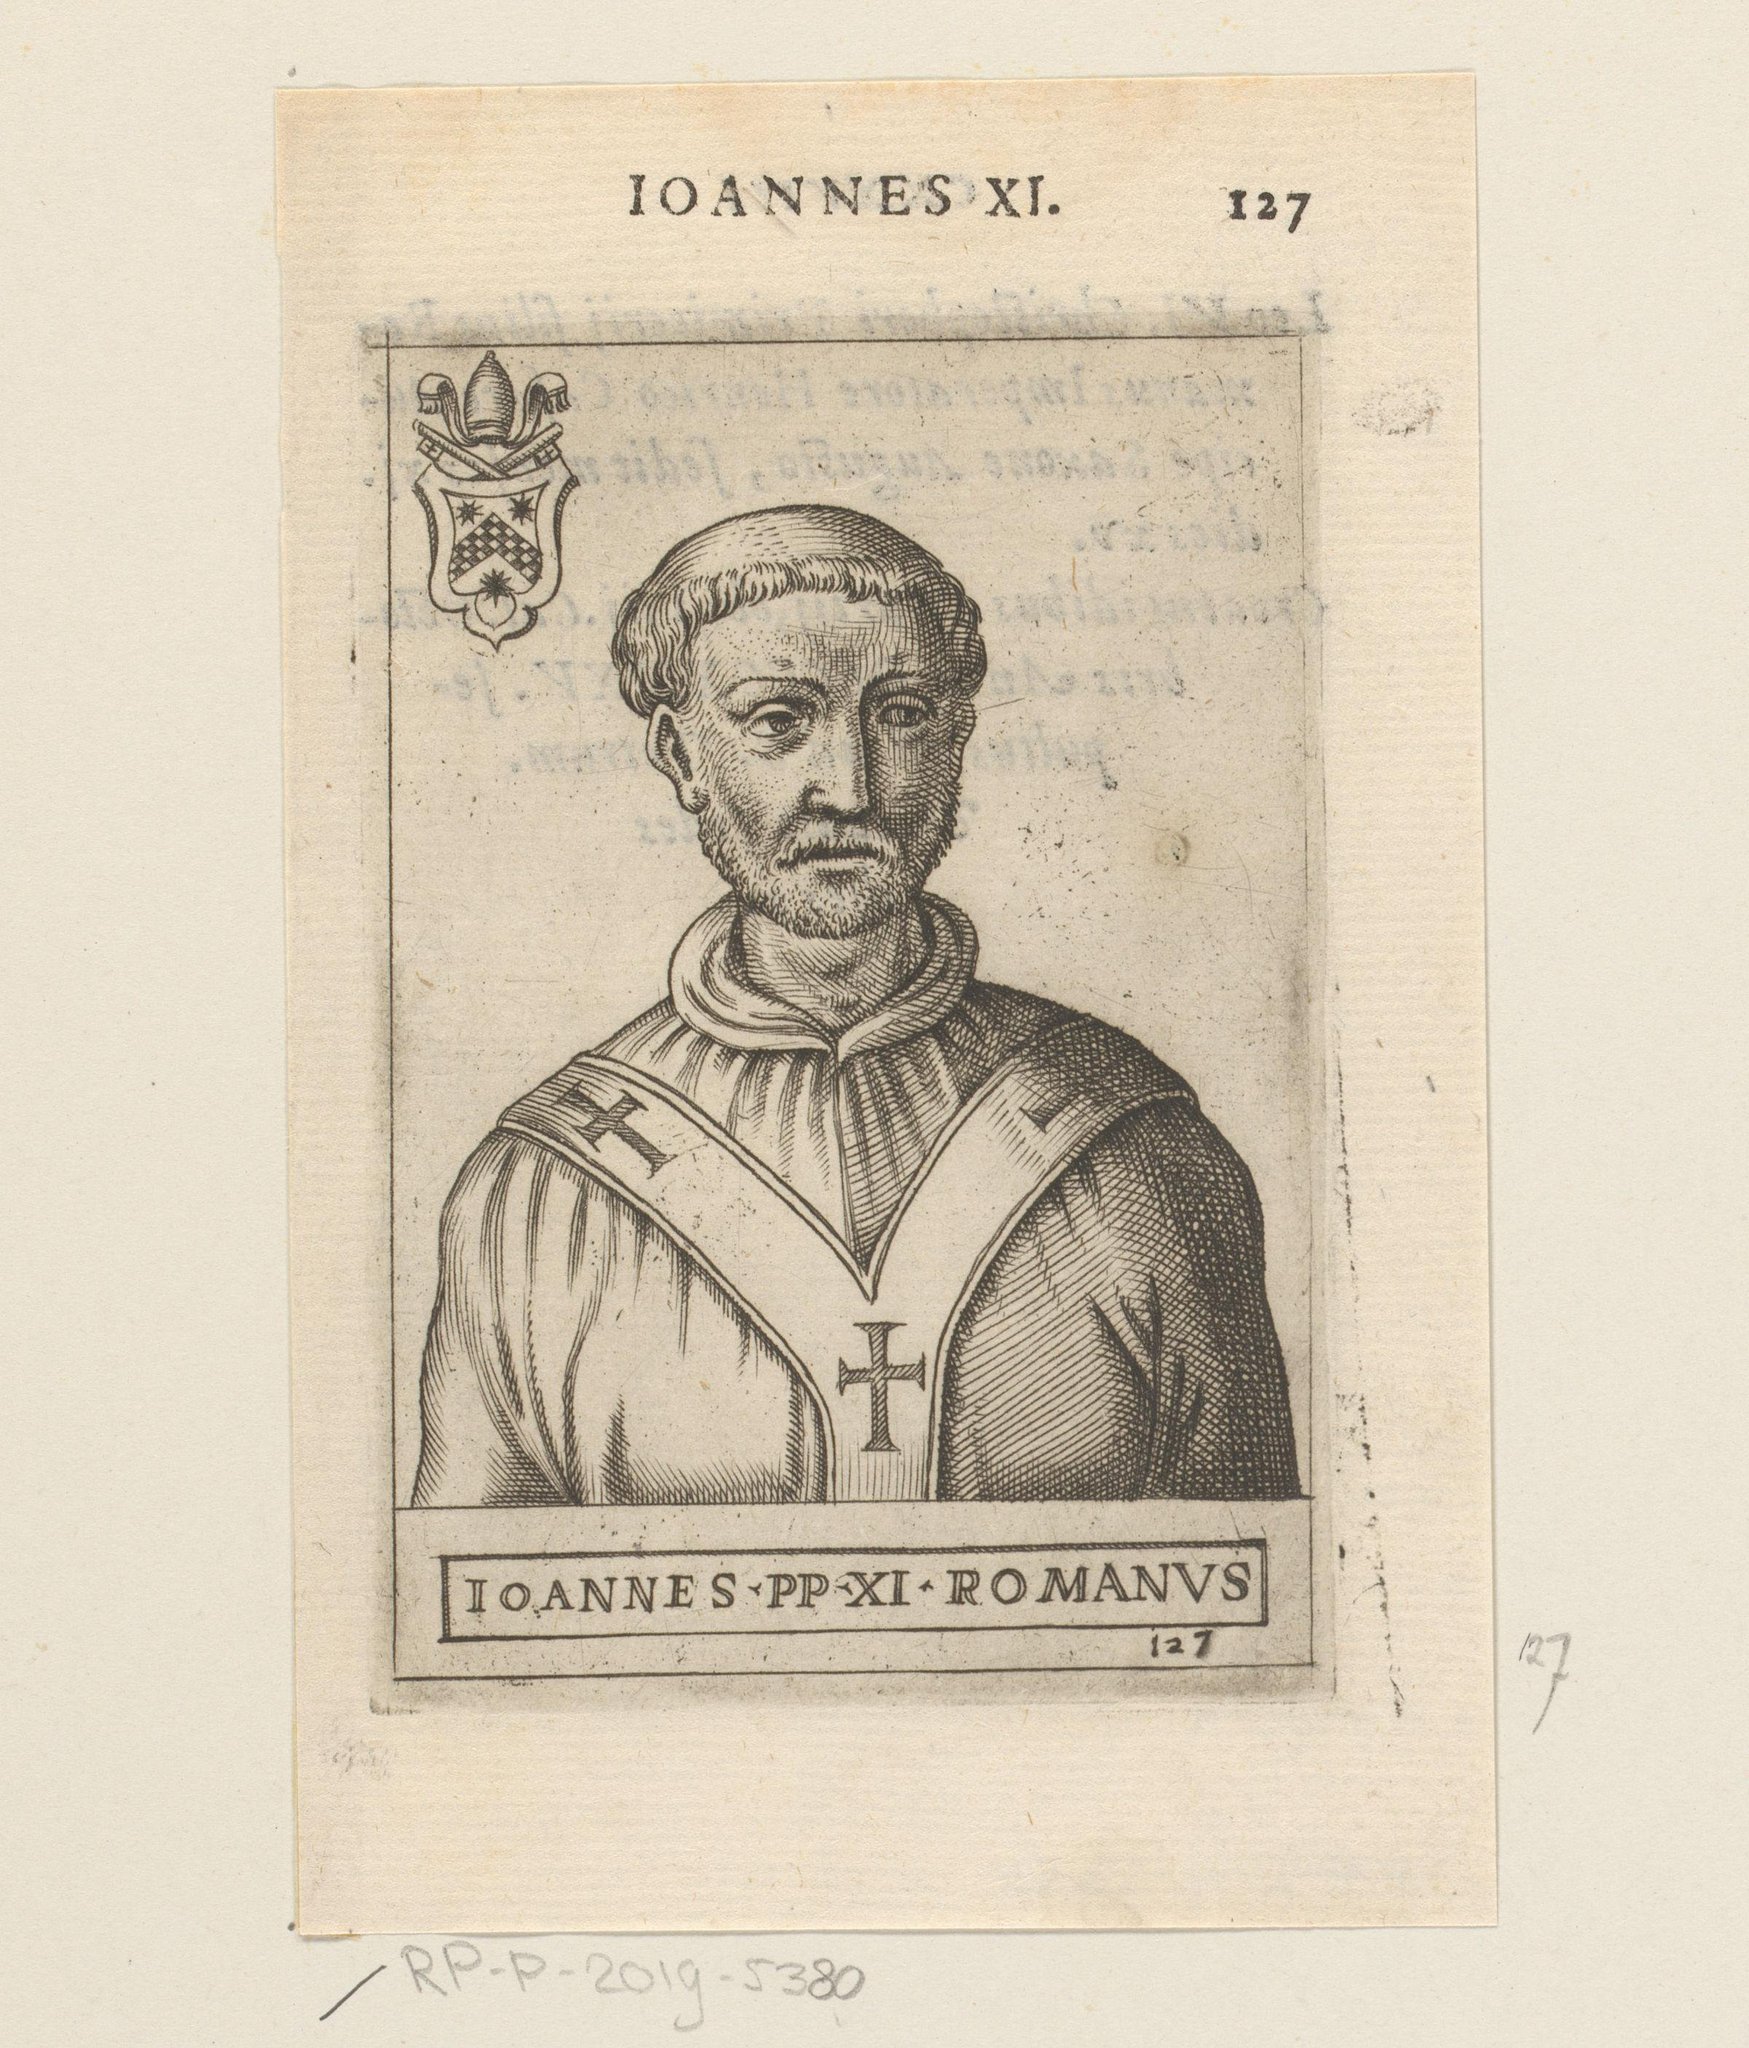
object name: print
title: Joannes PP XI Romanus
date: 1595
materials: paper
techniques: engraving, letterpress printing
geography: rome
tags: rome, historical persons, pope, armorial bearing, heraldry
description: Prent uit: Cavalieri, Giovanni Battista de'. Effigies pontificum romanorum cum eorum vitis (...). Rome: Bartolomeo Bonfadino, 1595. Prent voor het eerst verschenen in: Cavalieri, Giovanni Battista de'. Pontificum romanorum effigies (...). Rome: Domenico Basa en Francesco Zanetti, 1580. Prent ook gebruikt in latere publicaties.